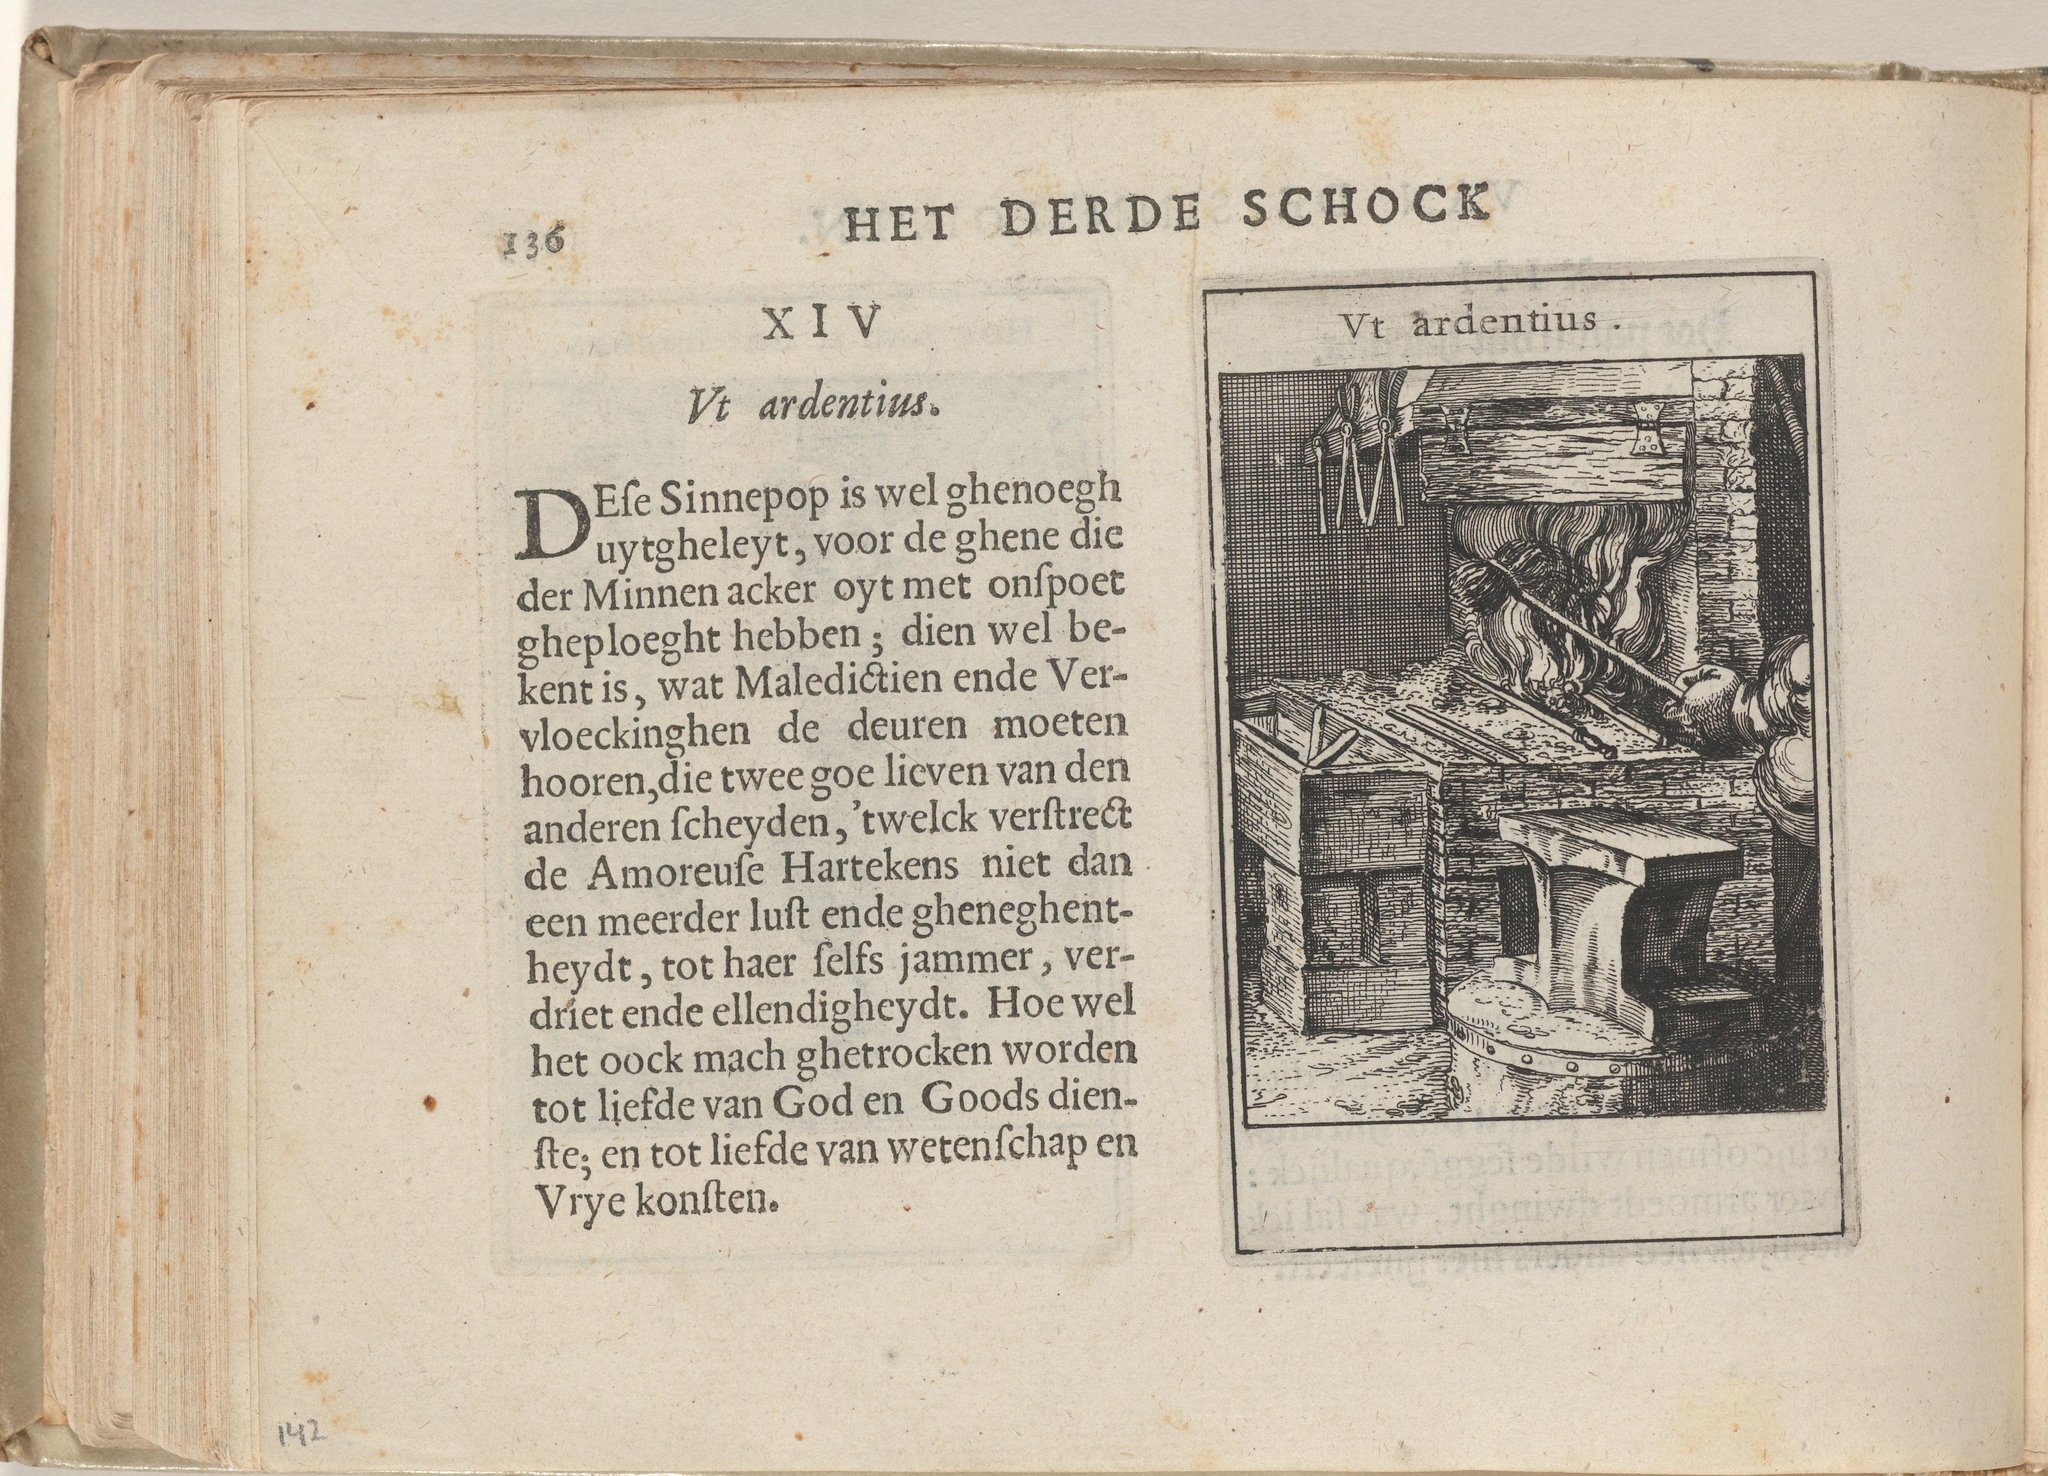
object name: album leaf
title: XIV Ut ardentius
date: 1614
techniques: engraving, printing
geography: the hague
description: XIV Ut ardentius. Derde schok. Onderdeel van 'Sinnepoppen', R. Visscher, 1614.